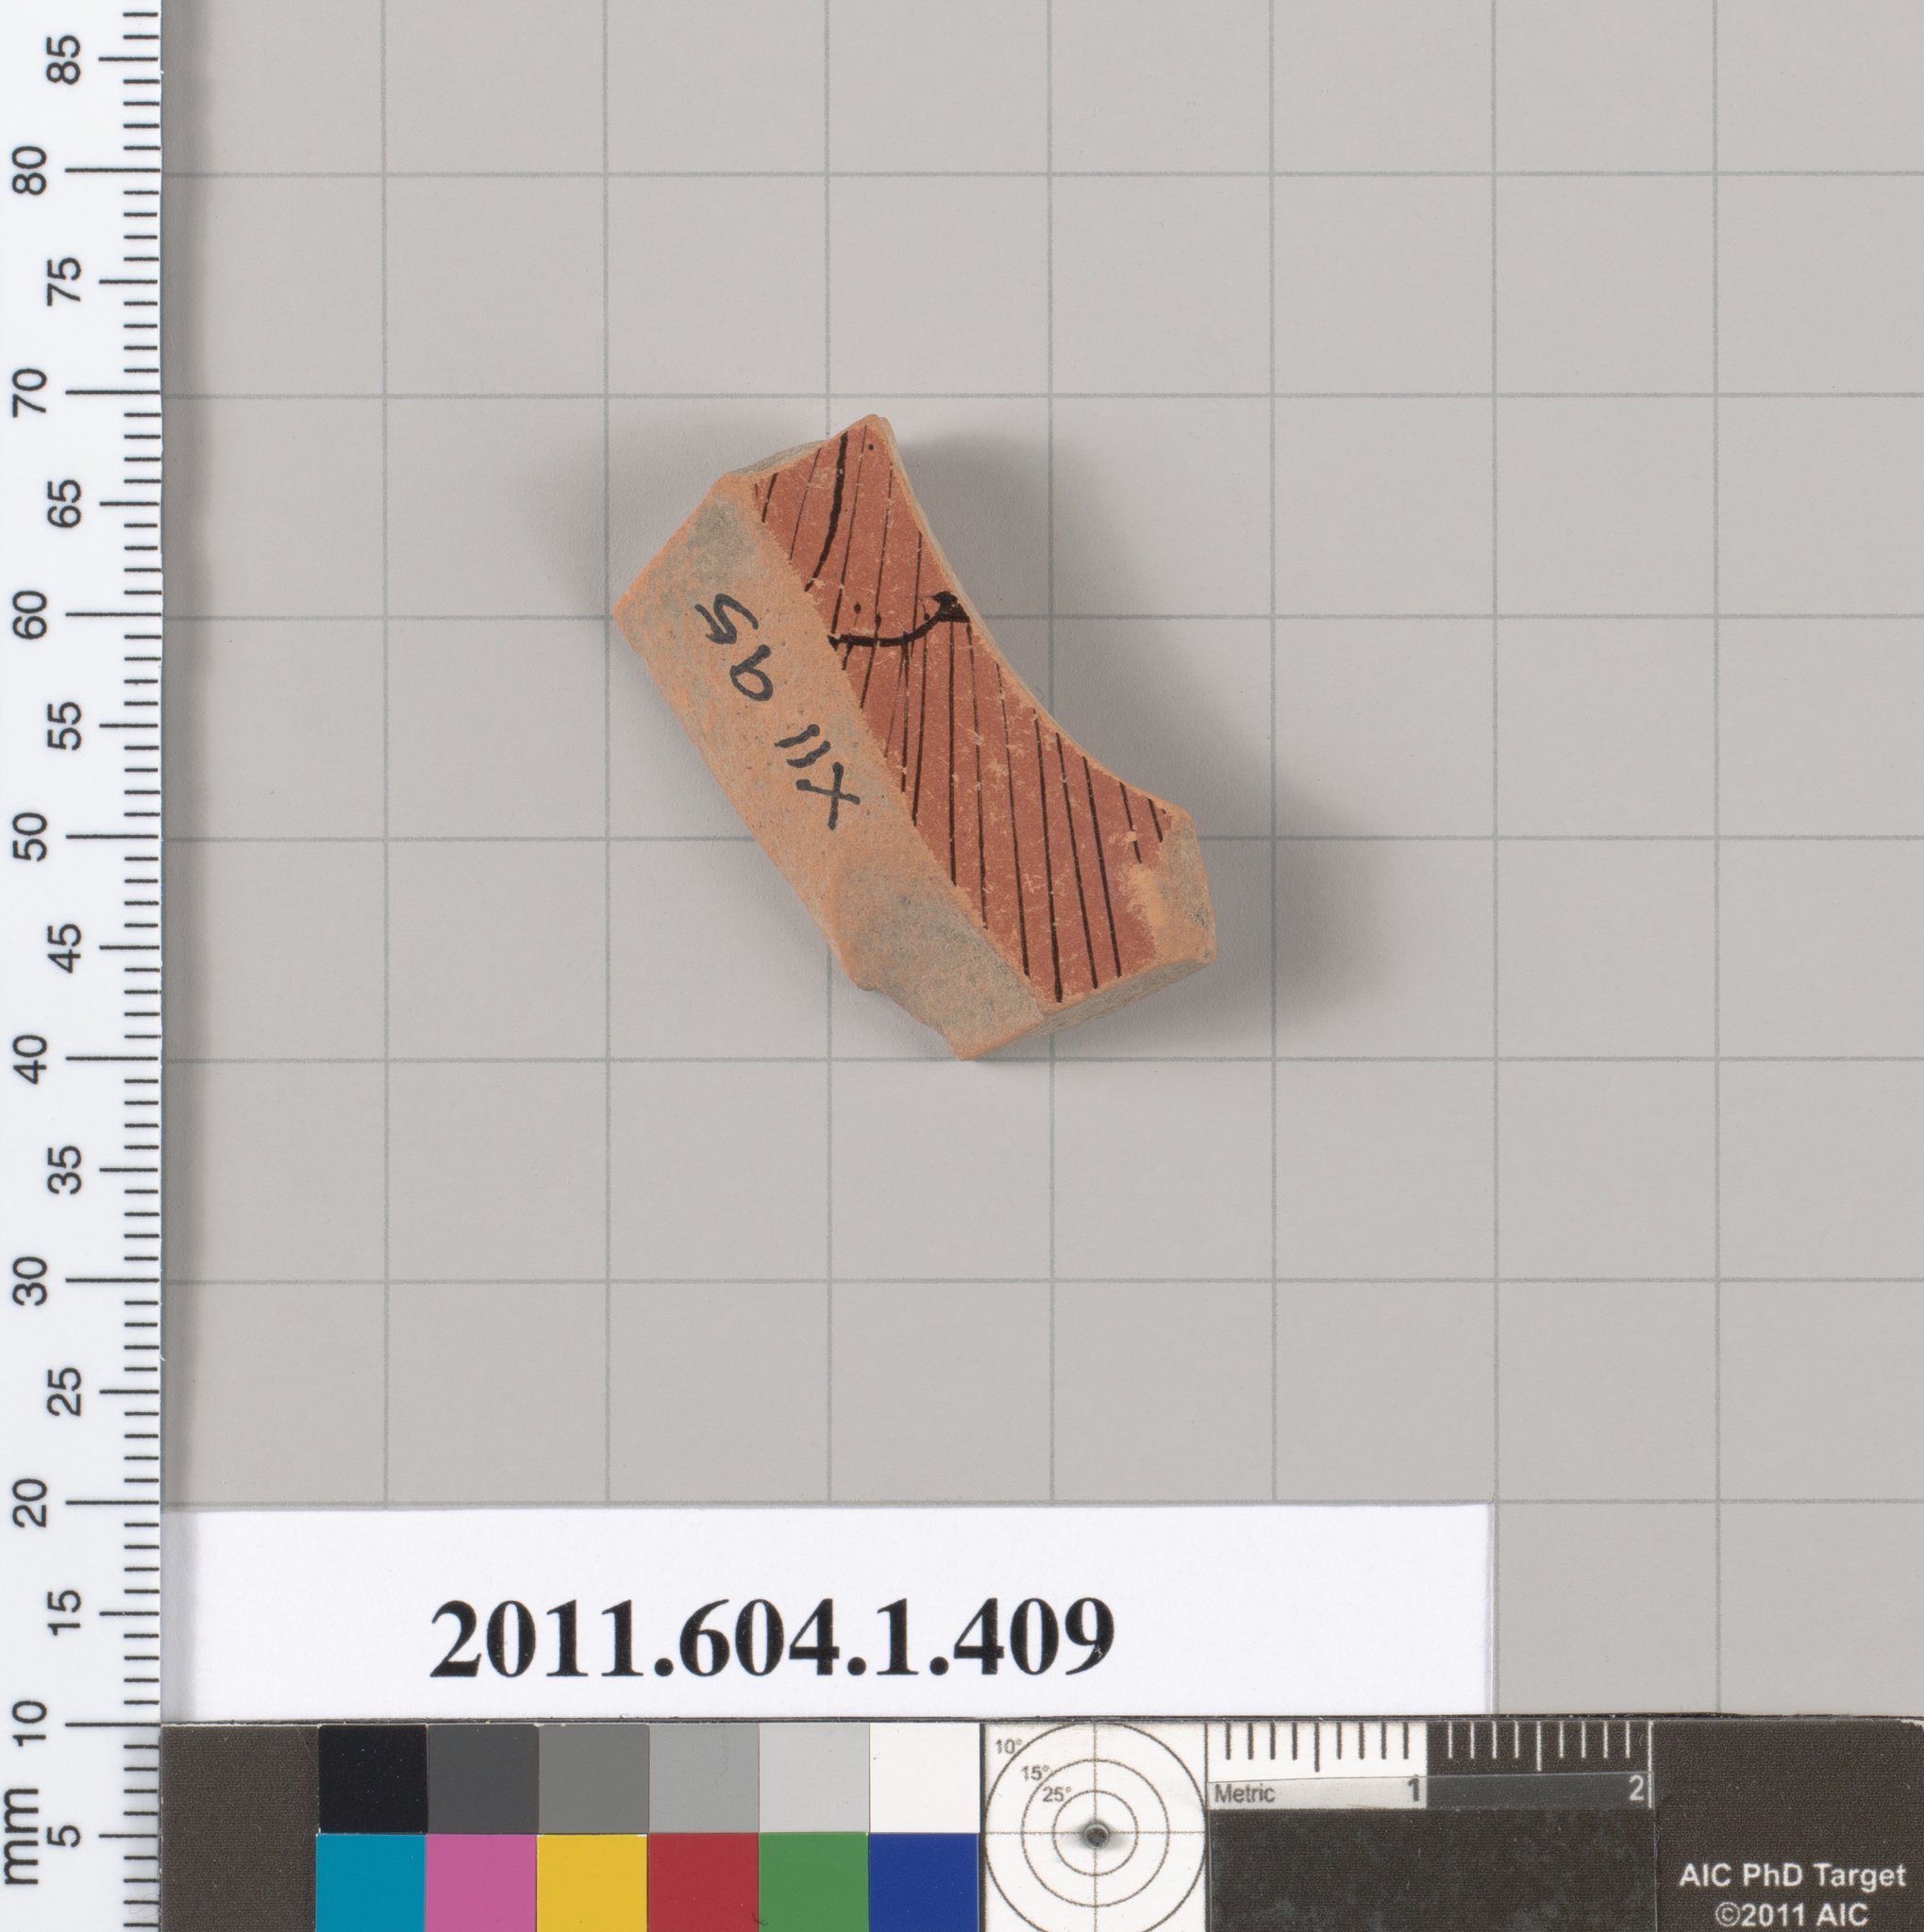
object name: kylix fragment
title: Terracotta fragment of a kylix (drinking cup)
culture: greek, attic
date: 475-451 BCE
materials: terracotta